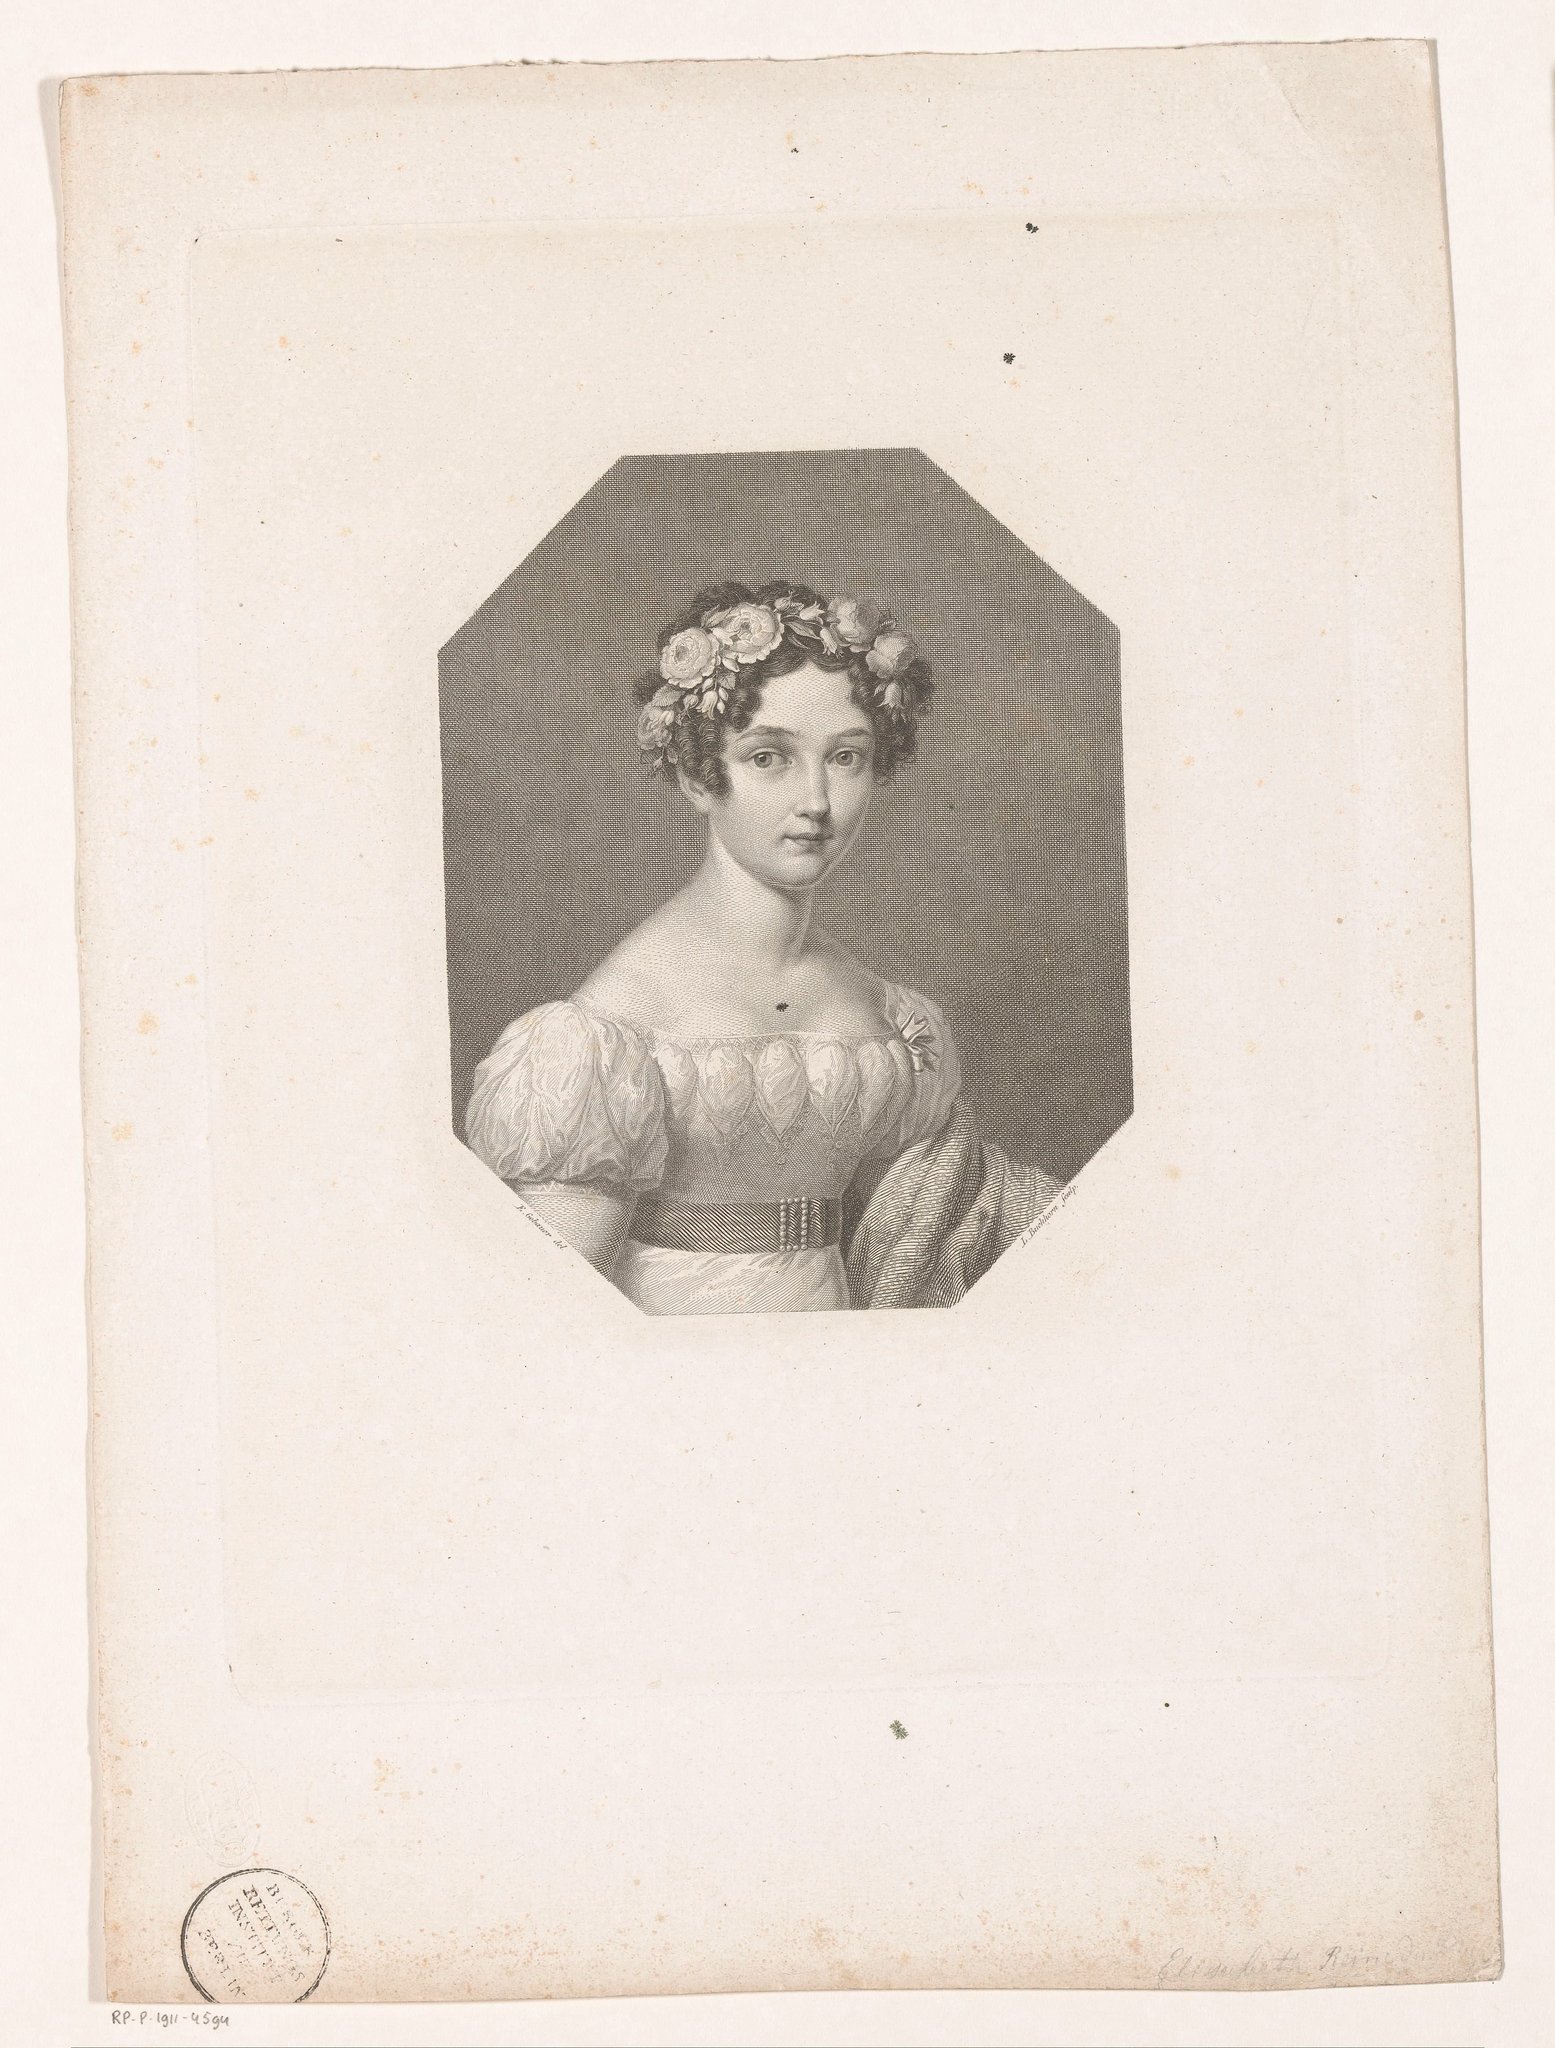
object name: print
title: Portret van Elisabeth Ludovika von Bayern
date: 1811-1856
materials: paper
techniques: engraving, etching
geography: berlin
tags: historical persons - bb - woman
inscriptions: collector's mark: ‘Burger / Rettungs / Institut / zu / Berlin’, : ‘CFK (?)’, collector's mark: Lugt 2228